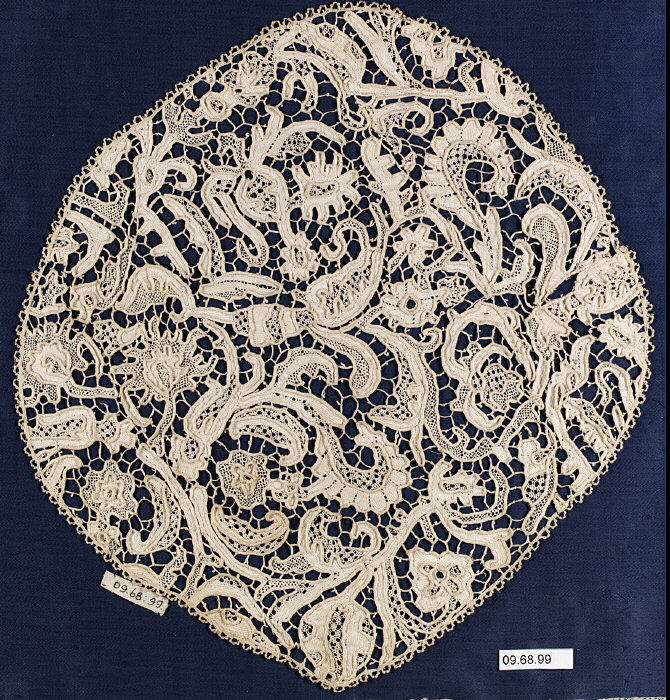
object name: piece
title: Round piece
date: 1601-1700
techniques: lace